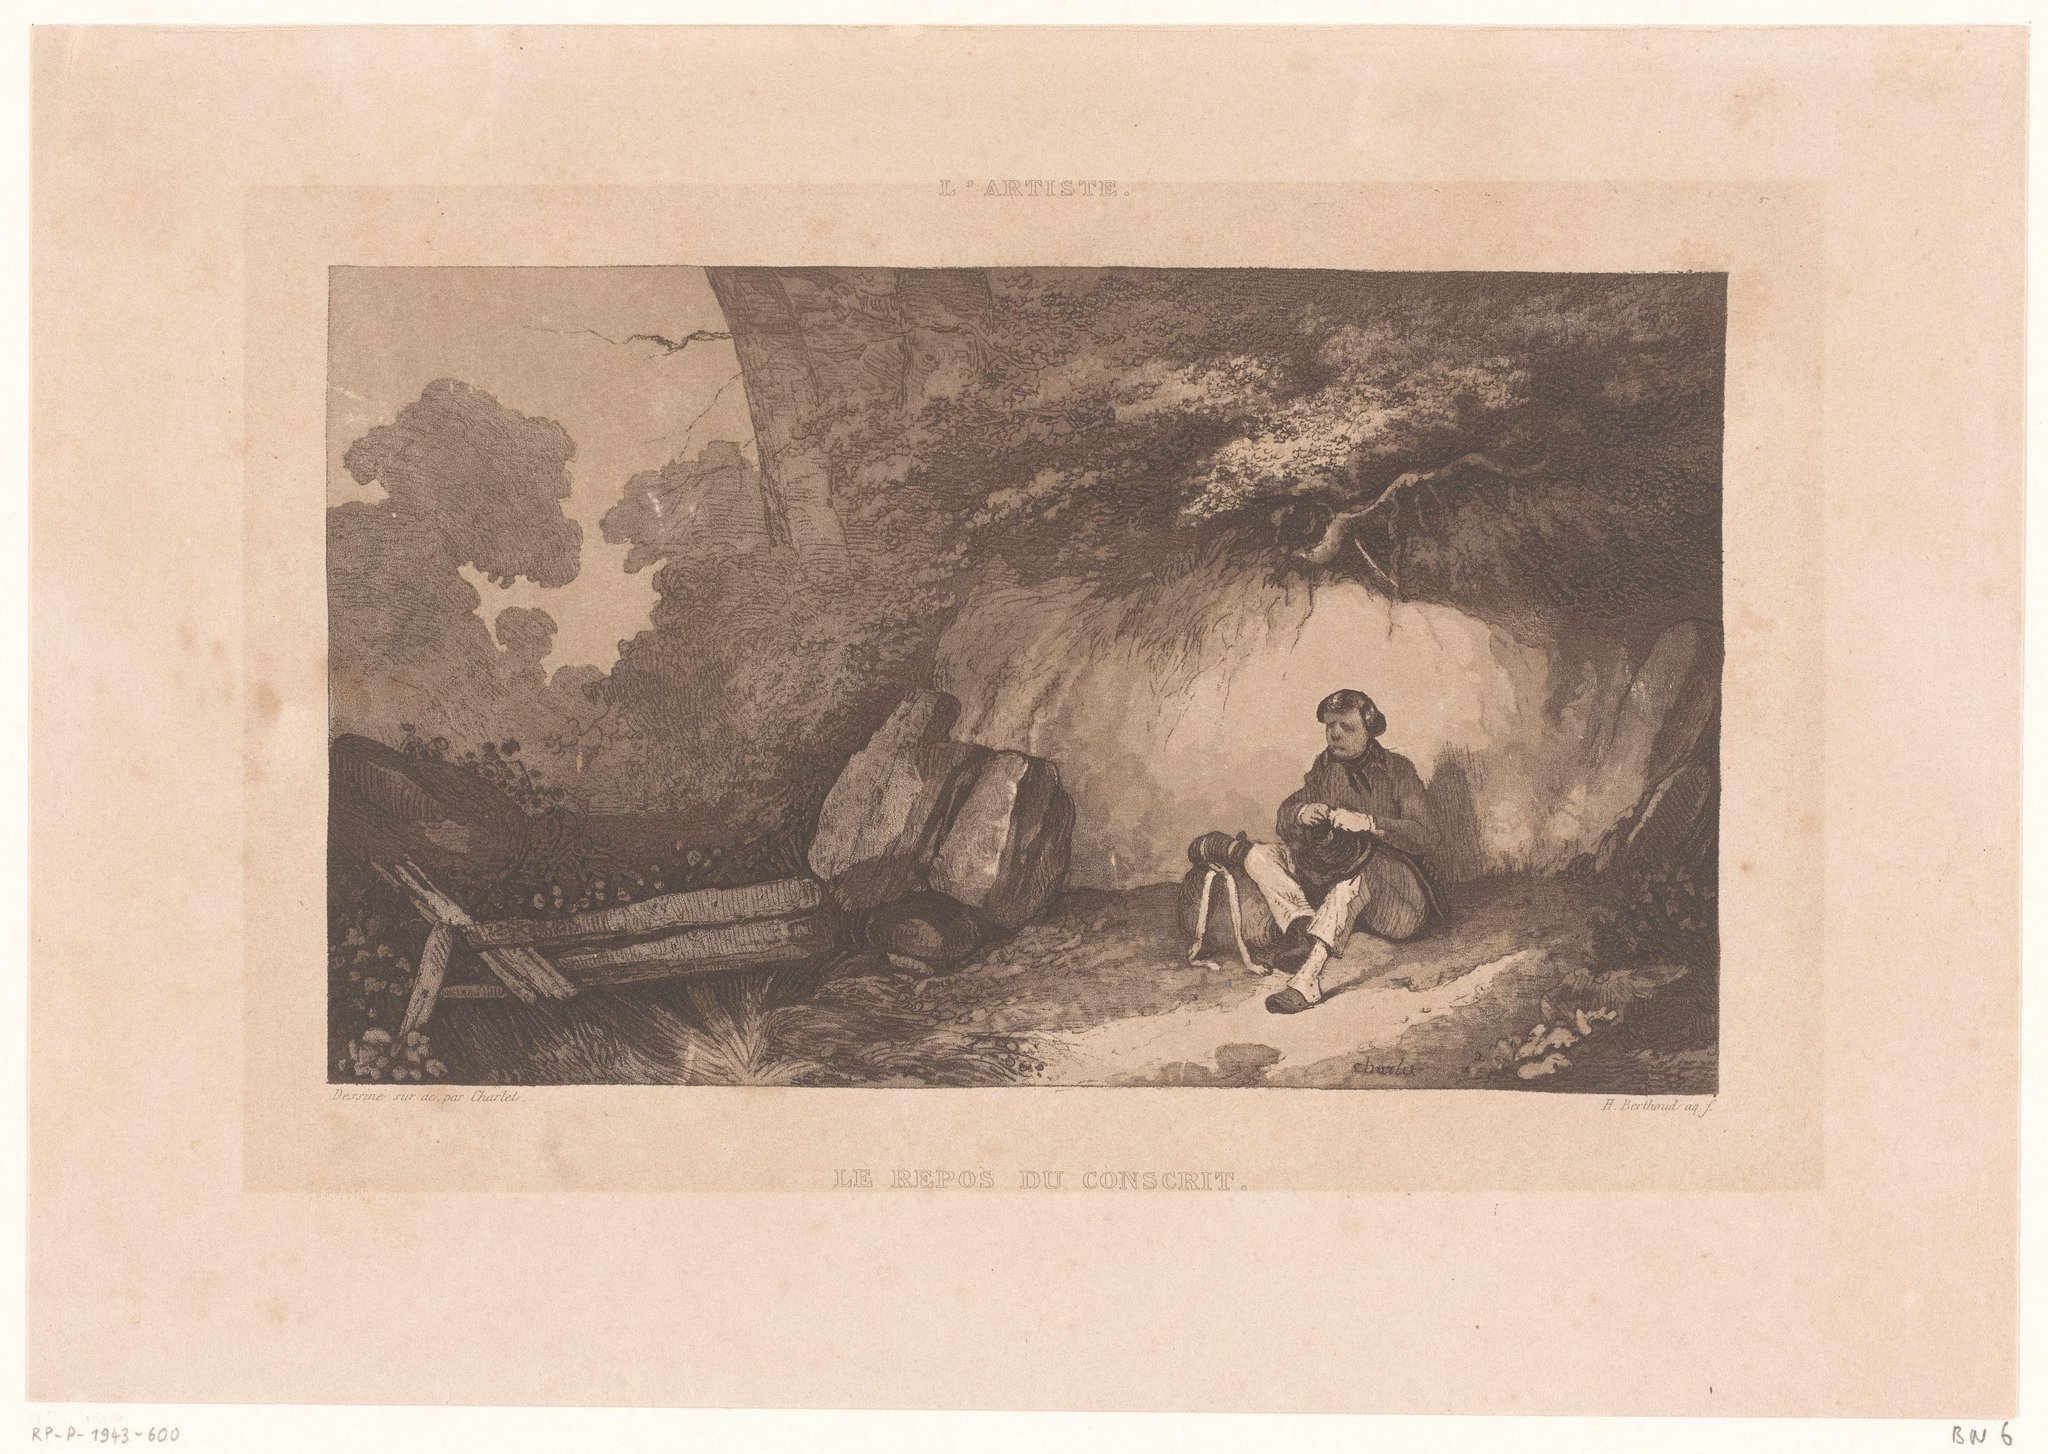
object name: print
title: Rotswand met rustende man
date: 1839-1845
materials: paper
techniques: aquatint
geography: france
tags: rock-formations, resting - bb - out of doors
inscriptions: check stamp: ‘L'artiste / hte -Del’, collector's mark: Lugt 2228